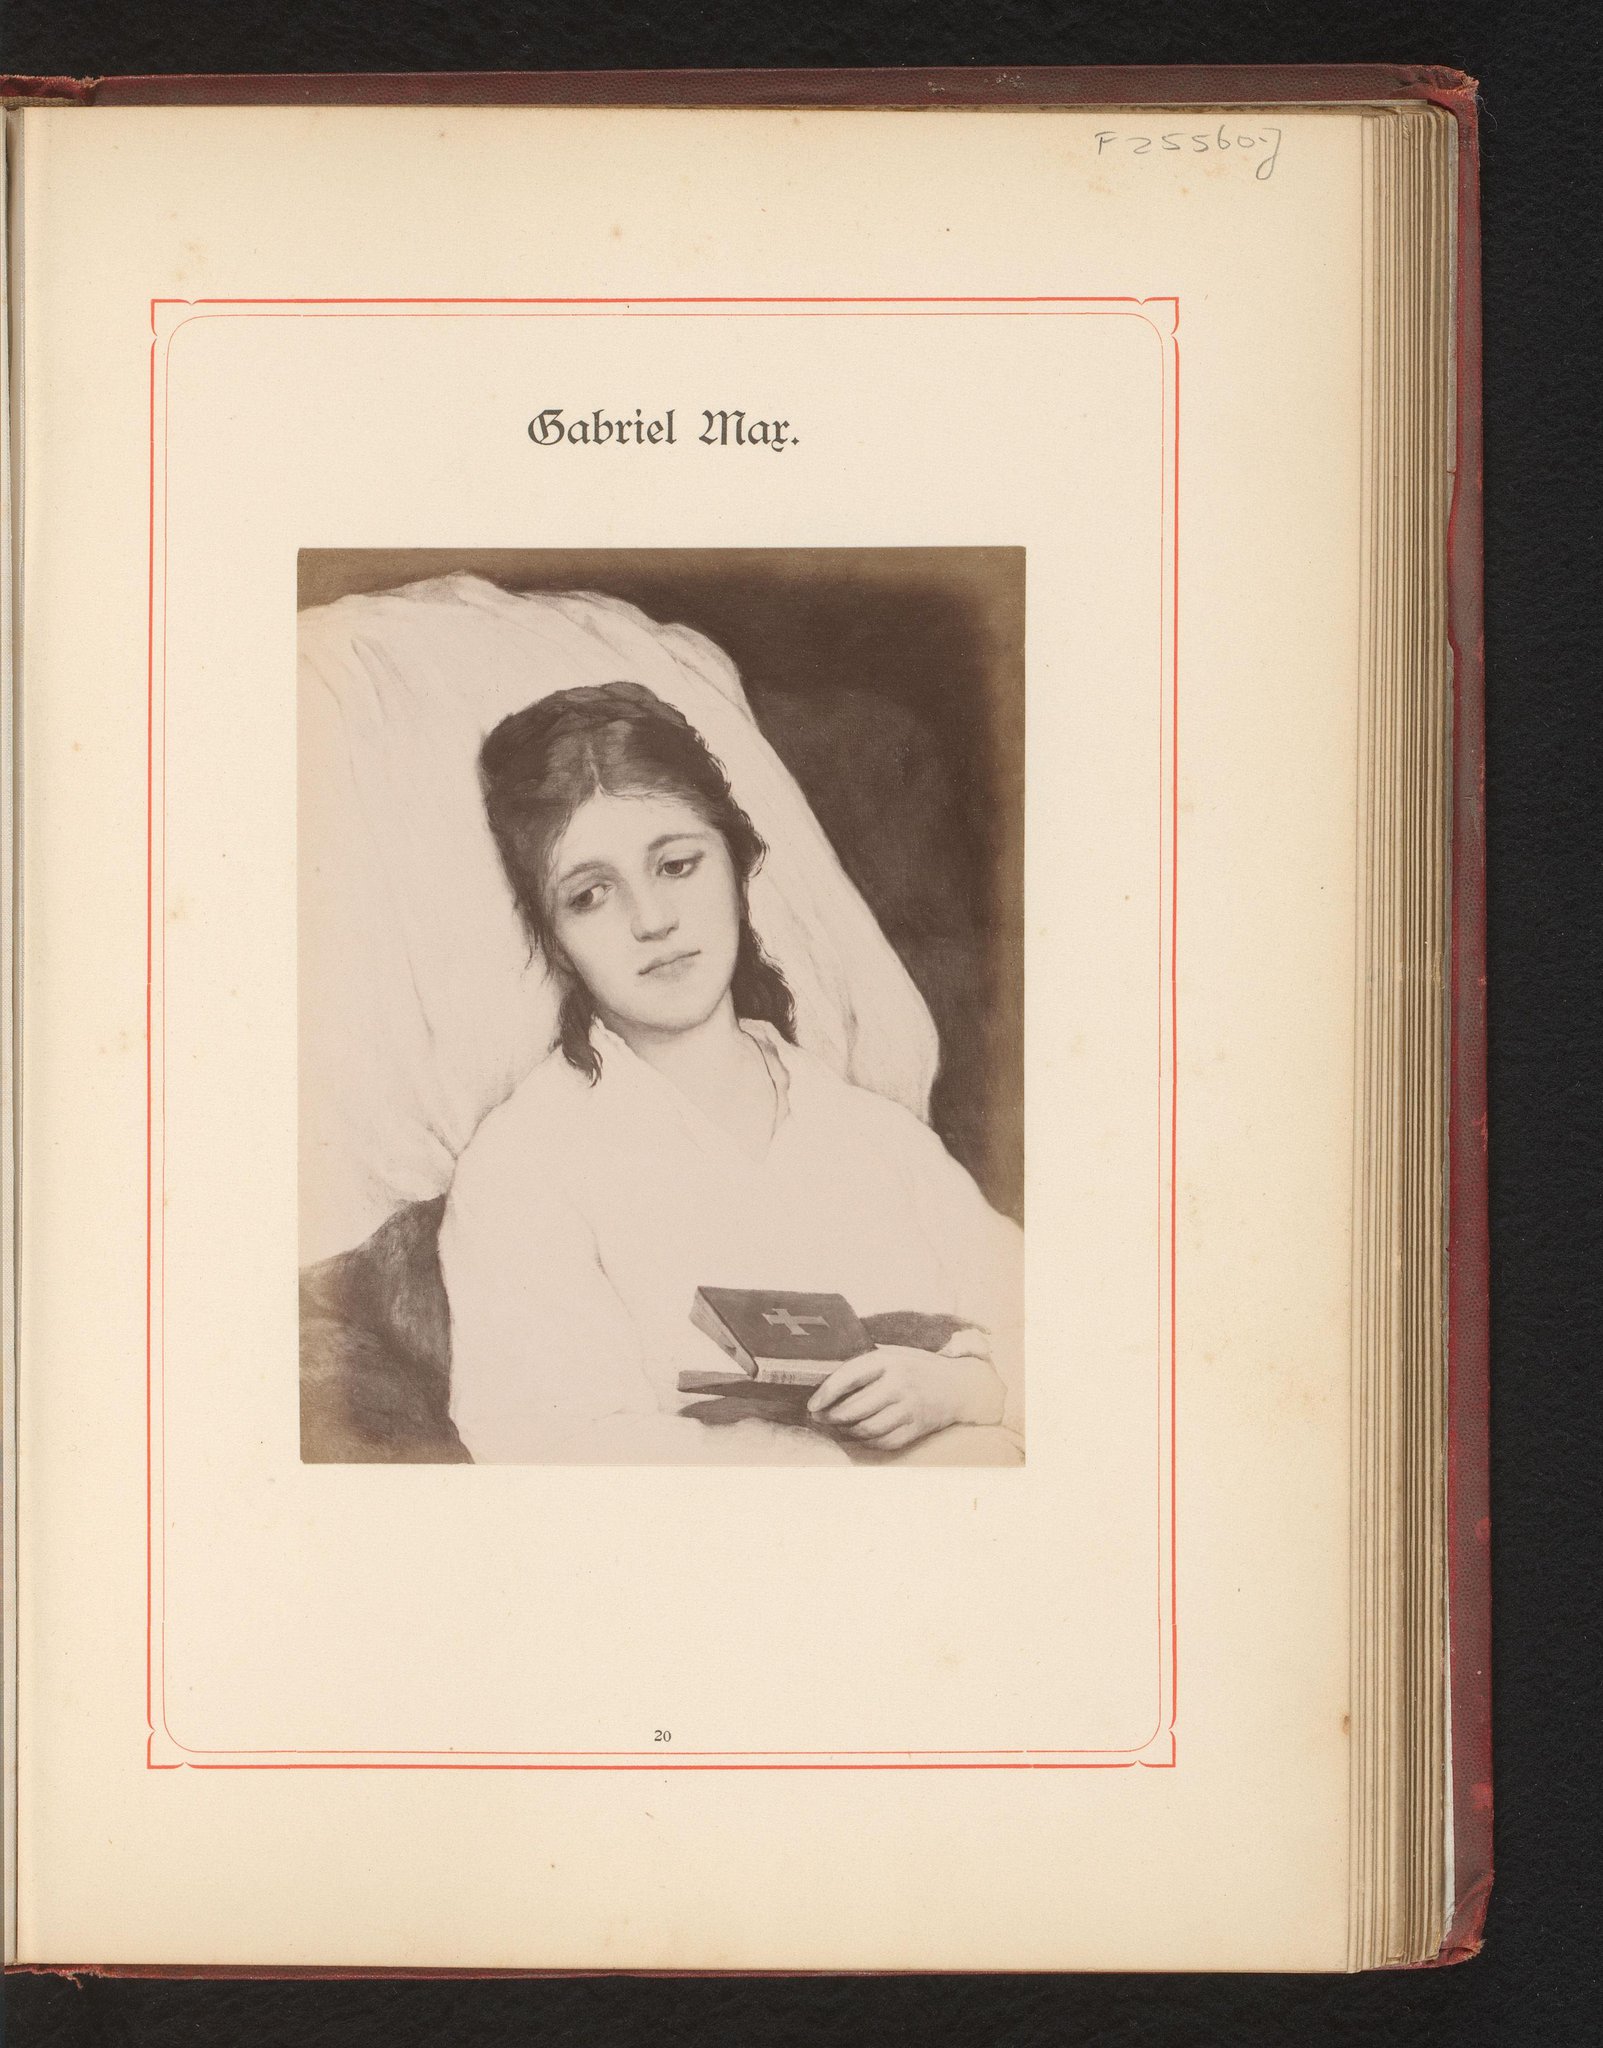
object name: reproduction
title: Fotoreproductie van een schilderij van een meisje in bed met bijbel in de hand door Gabriel Max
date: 1870-1890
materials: paper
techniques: albumen print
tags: girl (child between toddler and youth), bed, picture, painting